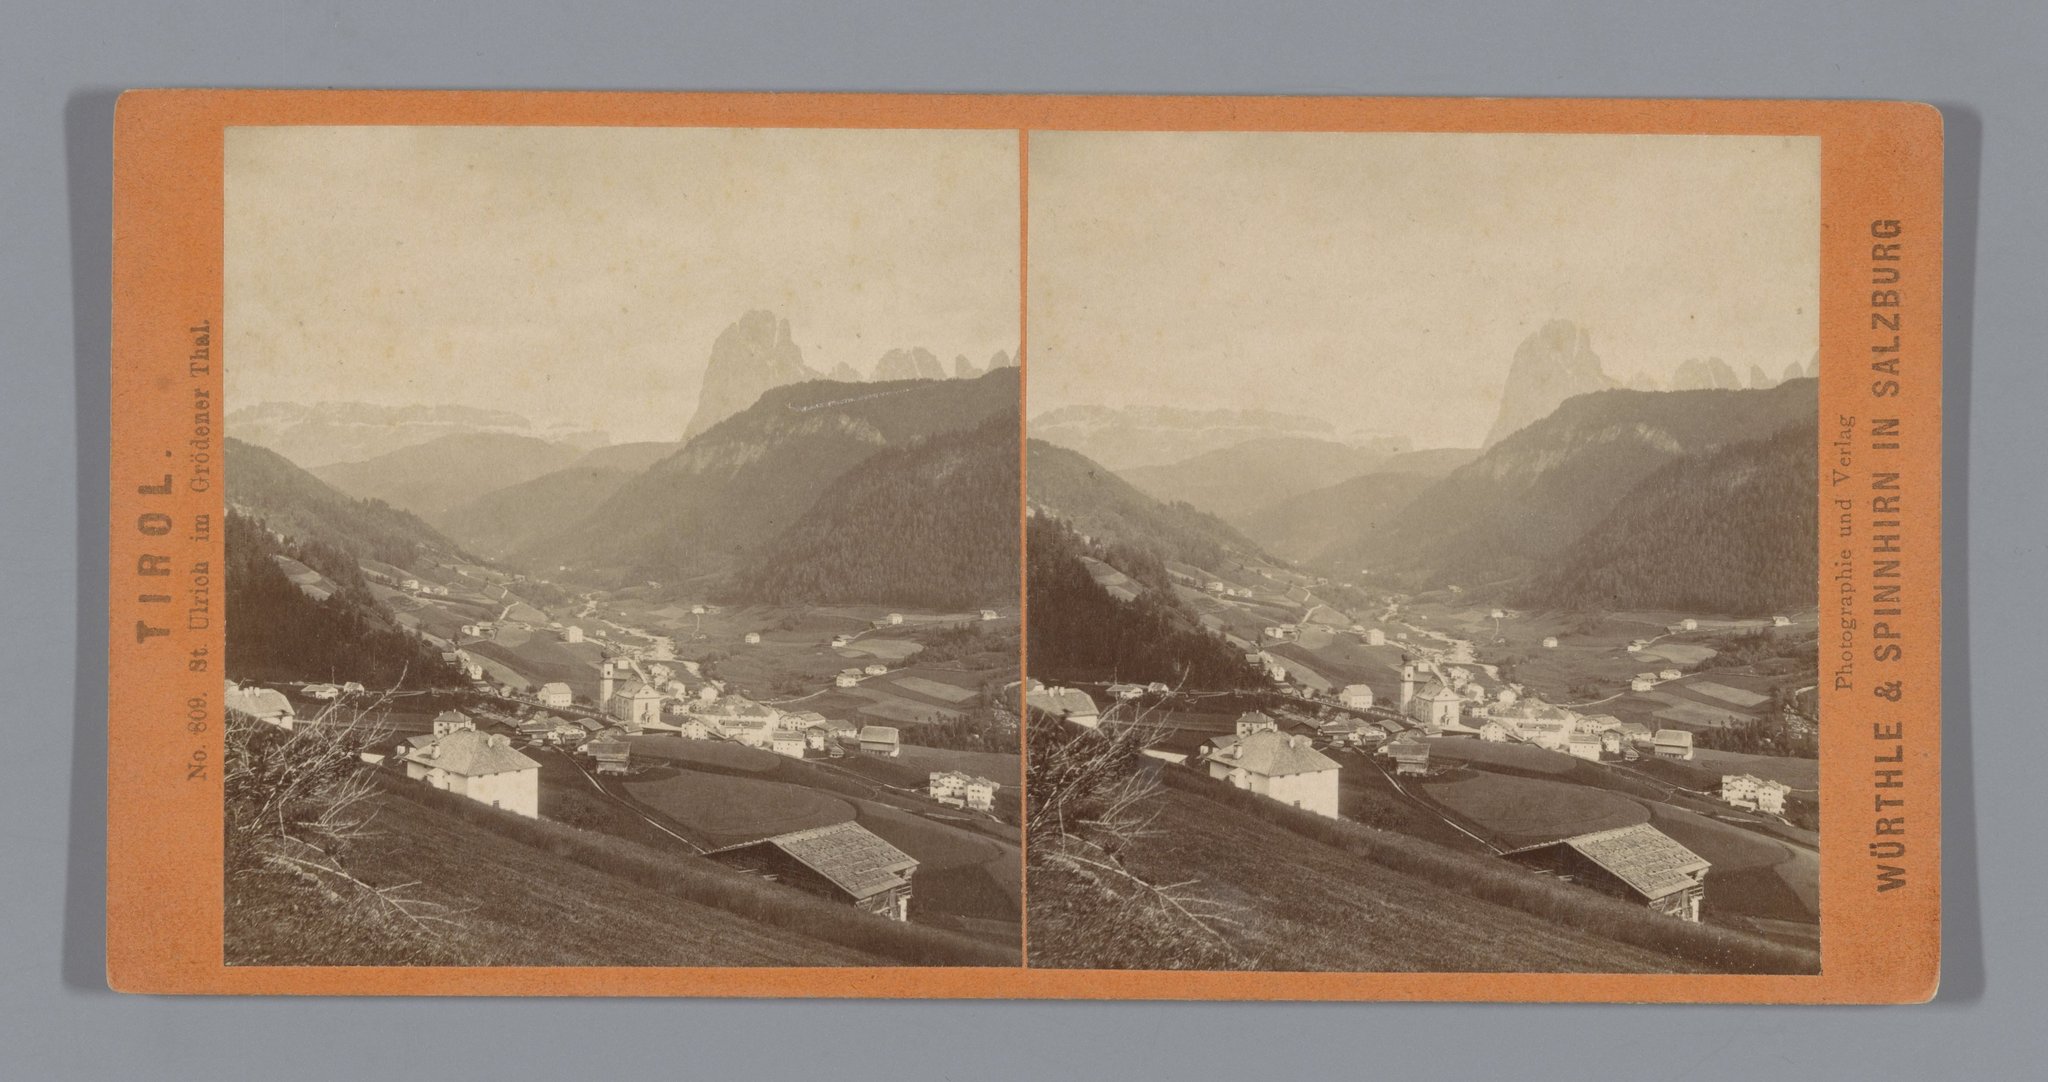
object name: stereograph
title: Gezicht op Urtijëi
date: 1860-1900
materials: cardboard, photographic support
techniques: albumen print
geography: south tyrol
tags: city-view in general; 'veduta', mountains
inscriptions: number: ‘No. 809.’